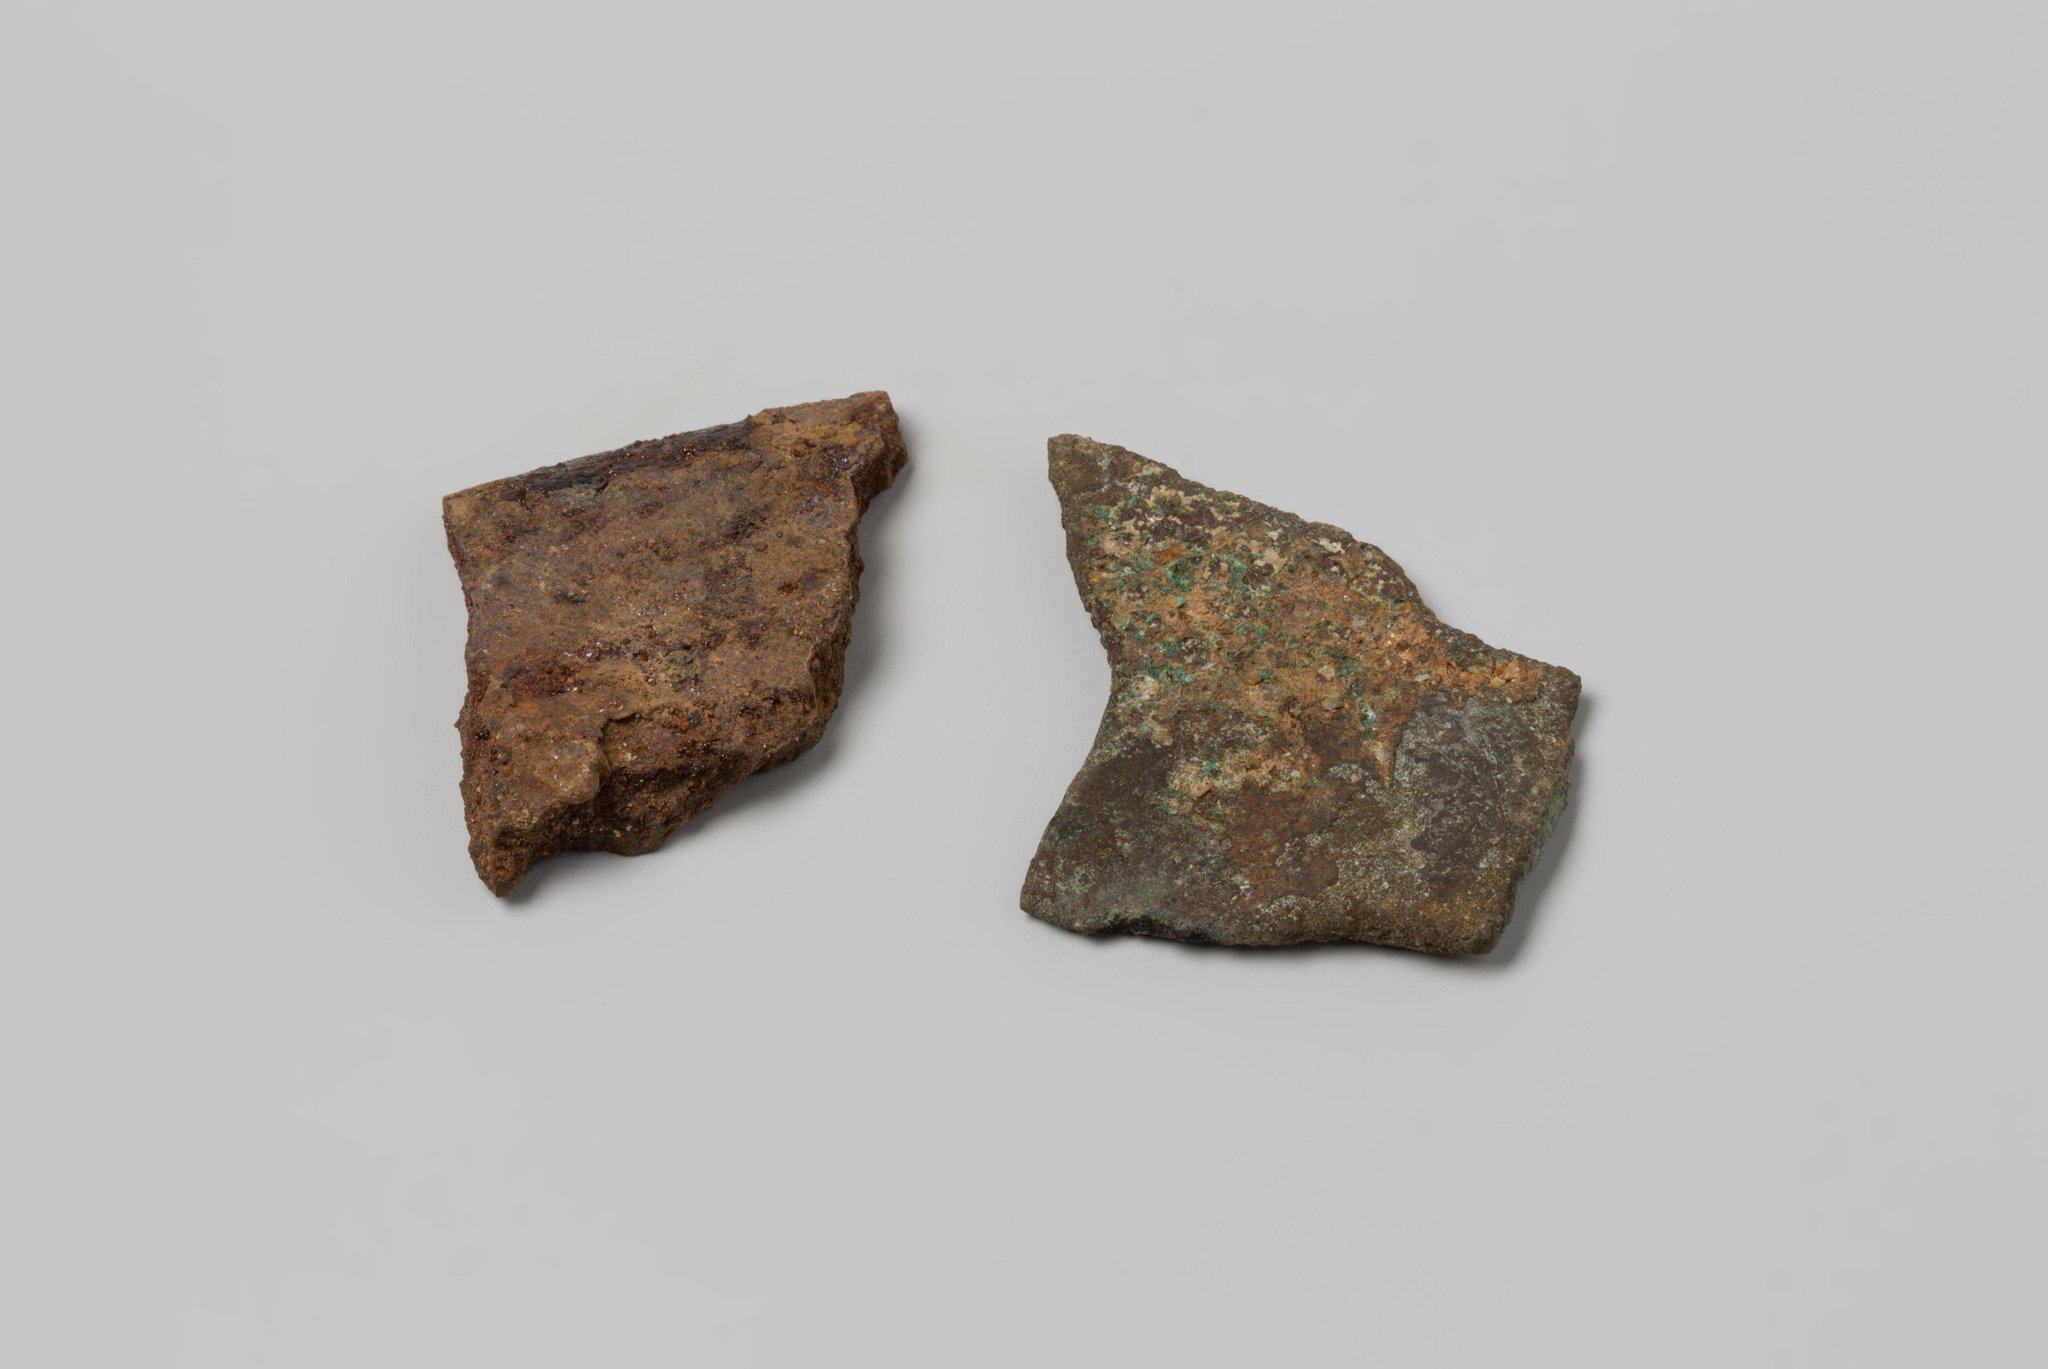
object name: fragment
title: Fragmenten koper uit het wrak van de Oost-Indiëvaarder Hollandia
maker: Anonymous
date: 1700-1743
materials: copper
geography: netherlands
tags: verenigde oostindische compagnie, hollandia (schip), annet